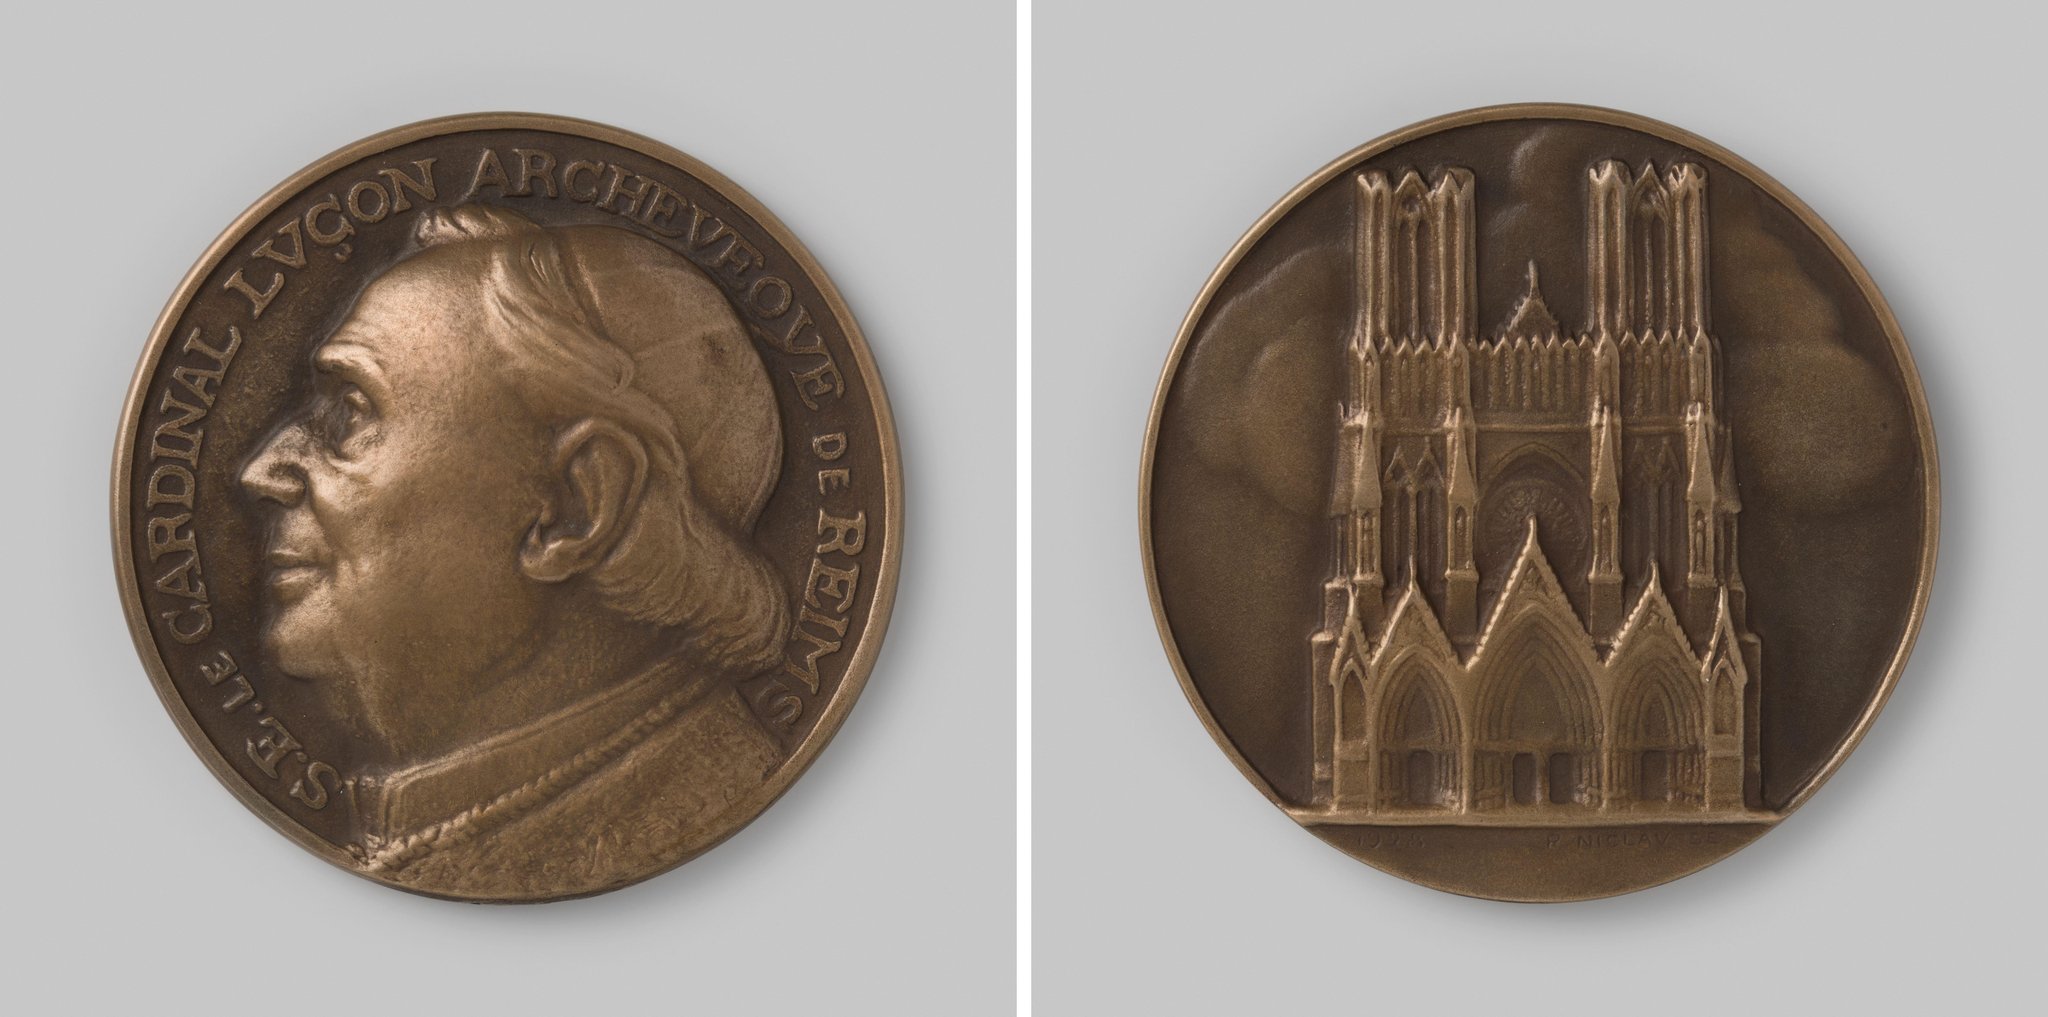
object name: history medal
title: Kardinaal Luçon Aartsbisschop van Reims (1928)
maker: paul niclausse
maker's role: sculptor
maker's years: 1879-1958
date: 1928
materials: bronze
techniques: casting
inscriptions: number: ‘(vierkant merk) 132’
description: Bronzen penning, op de voorzijde het borstbeeld van Luçon naar links met omschrift, op de keerzijde het aanzicht van de kathedraal van Reims.